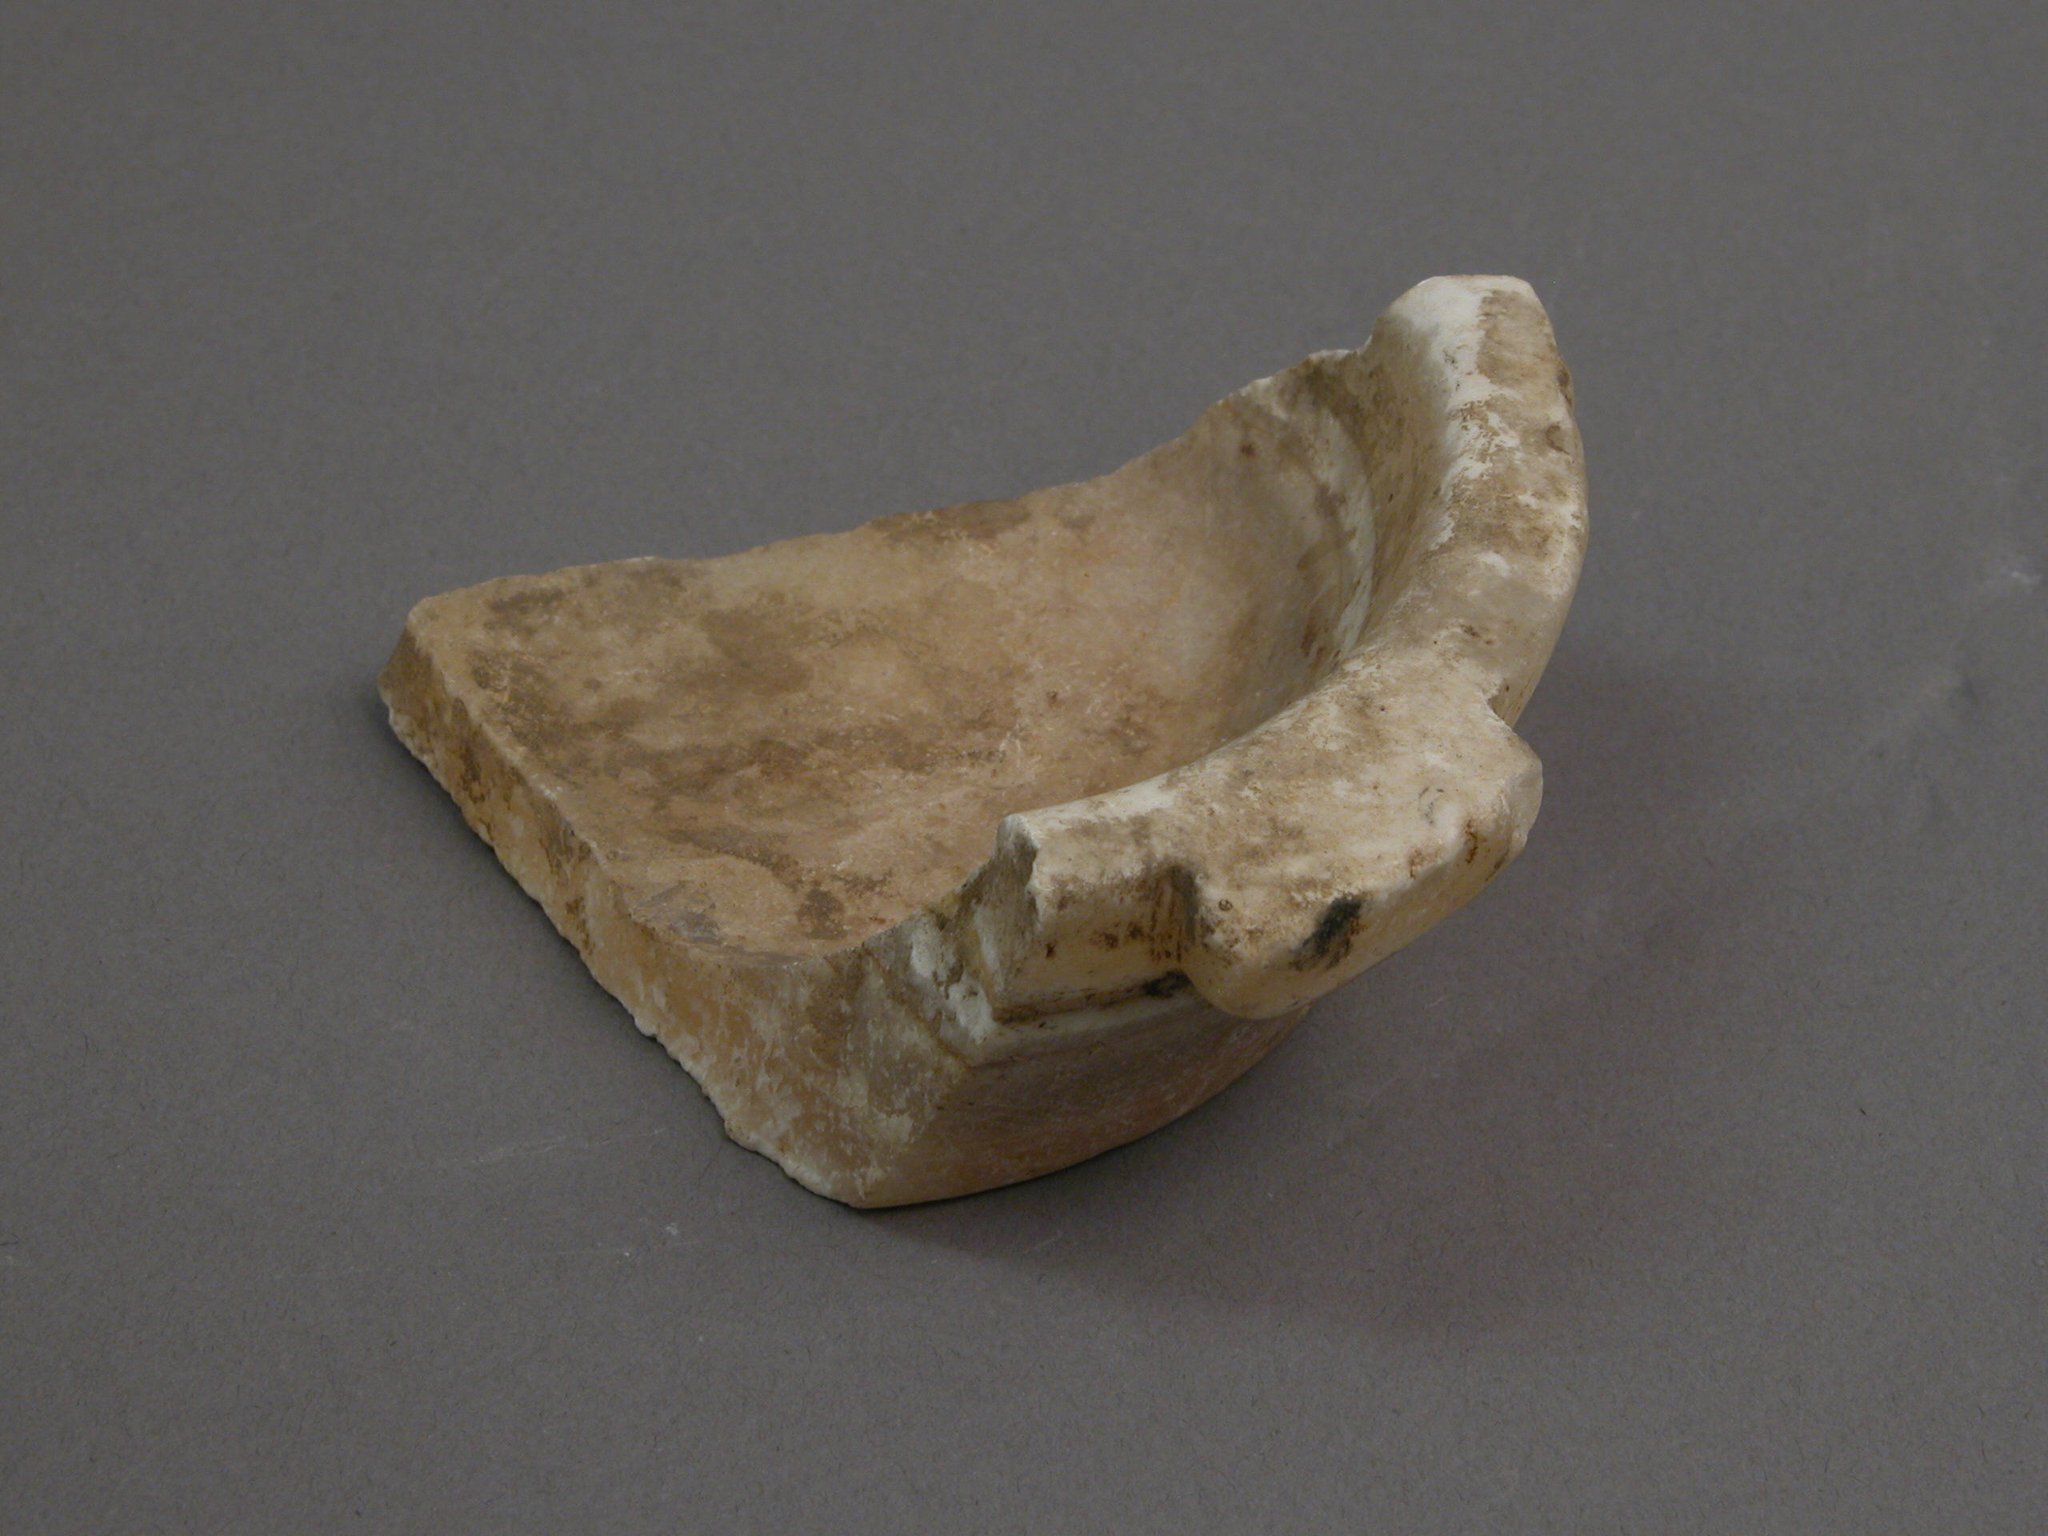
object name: fragment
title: Vessel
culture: coptic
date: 301-700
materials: alabaster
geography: egypt